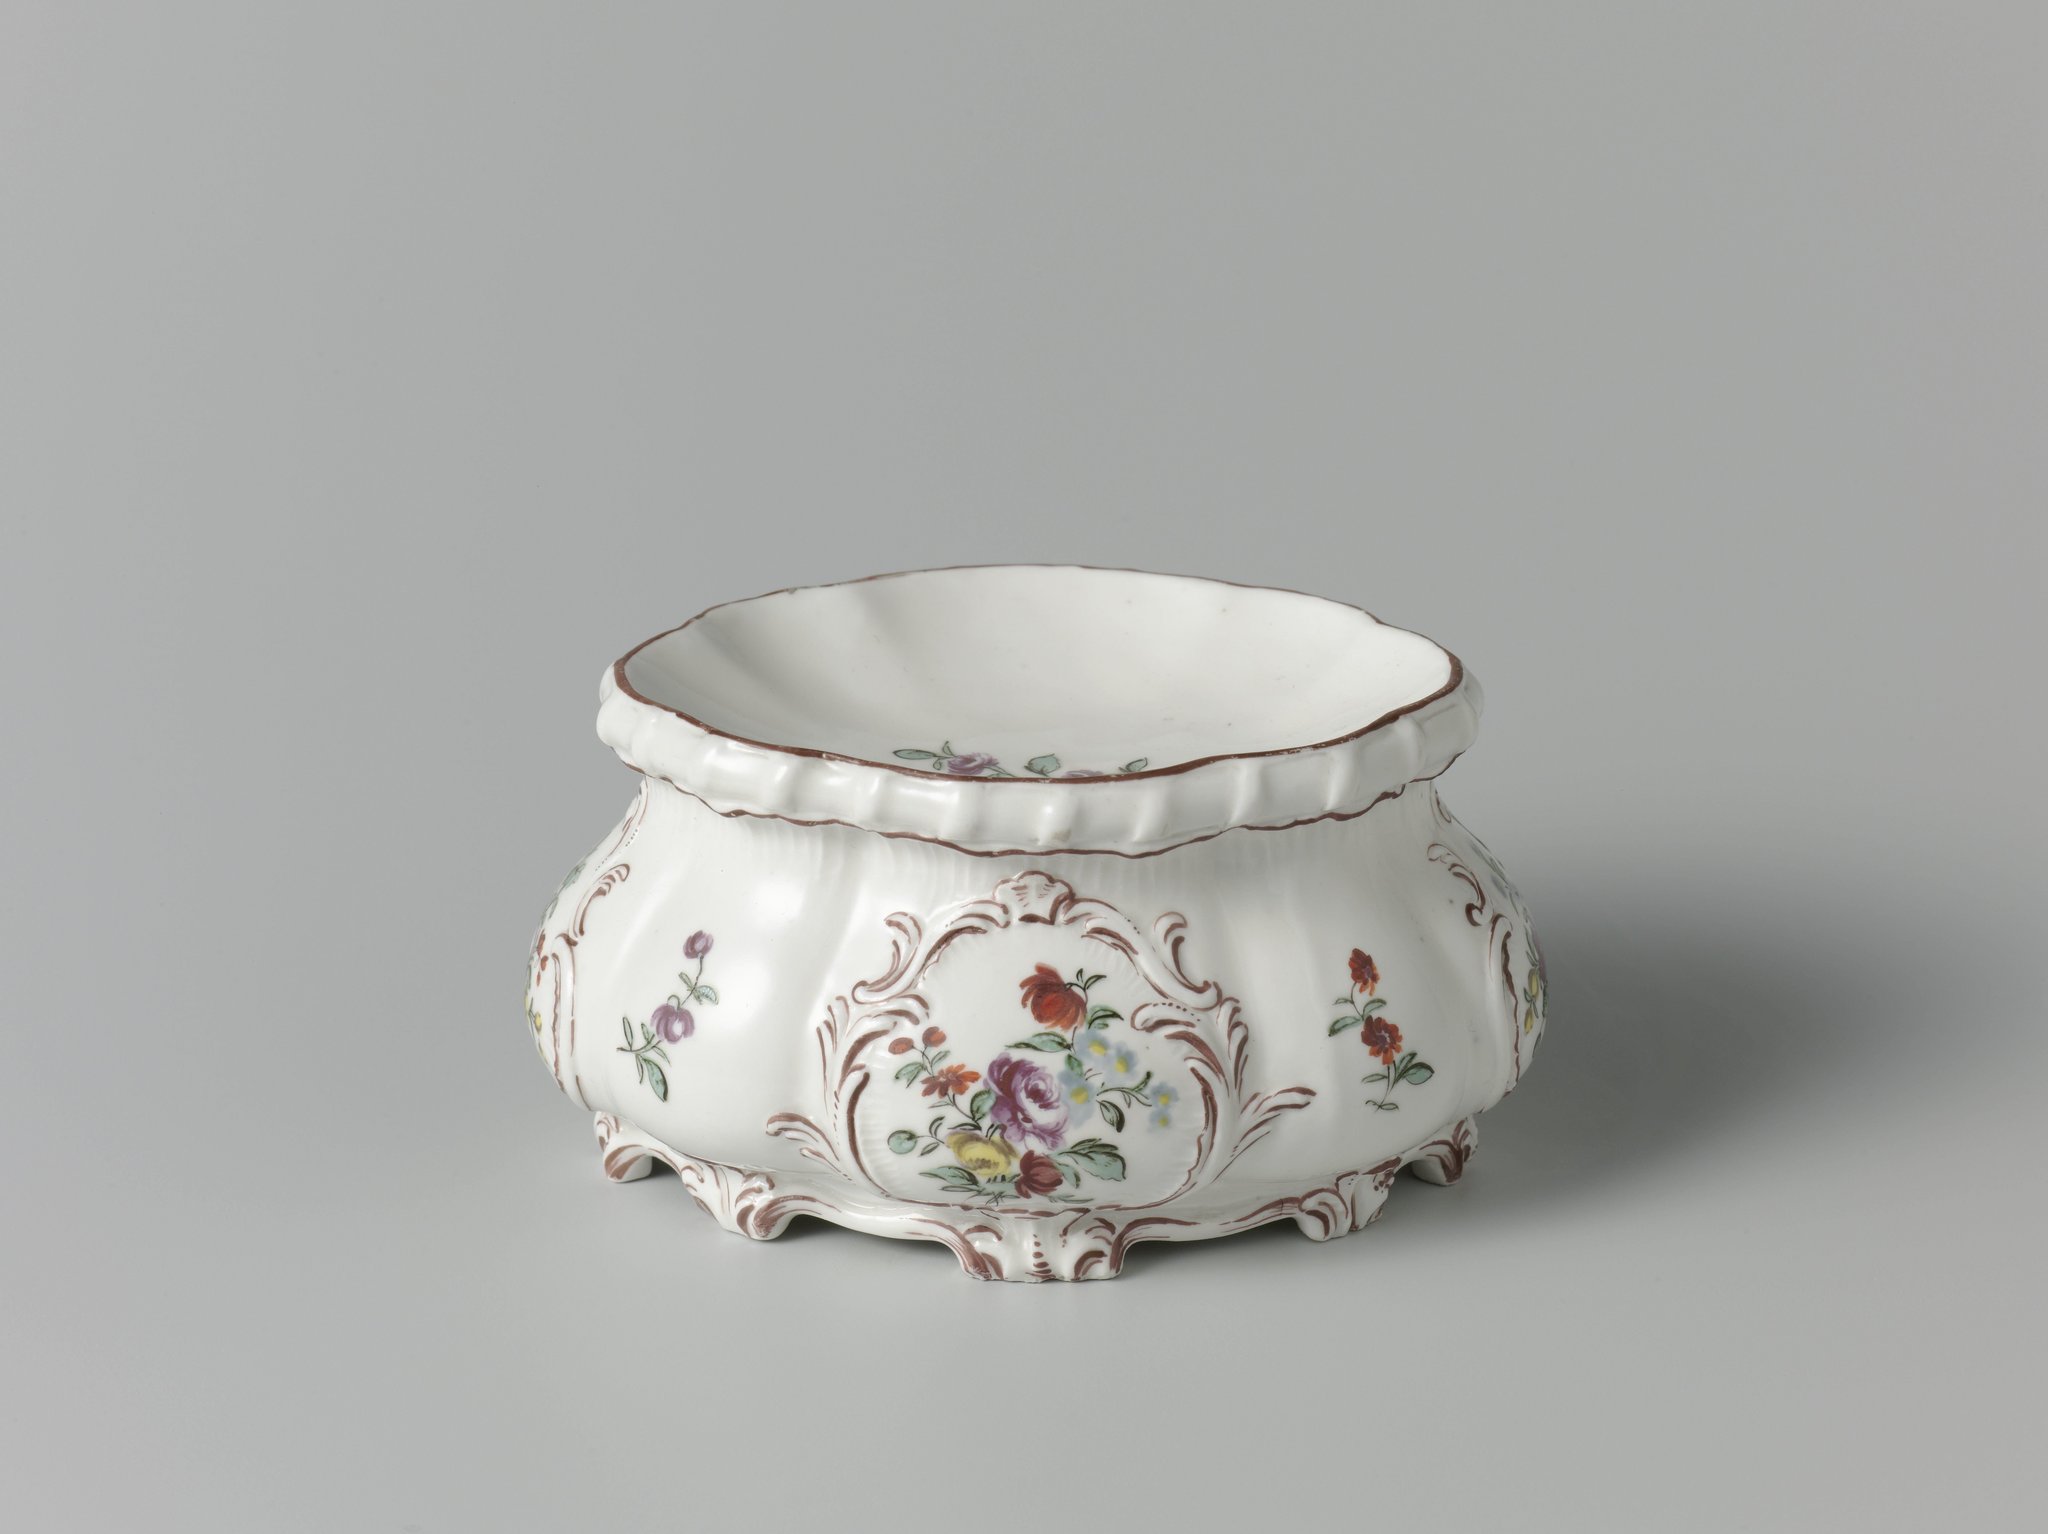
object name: salt condiment vessel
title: Pair of salt cellars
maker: christian gottlob berger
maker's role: garneerder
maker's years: 1730-1776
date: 1760-1761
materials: porcelain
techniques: painted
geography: weesp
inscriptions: factory mark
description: Weesper porseleinfabriek model attributed to Christian Gottlob Berger (1730–after 1776), c. 1760–1761 Weesp, c. 1764–1768 hard-paste porcelain